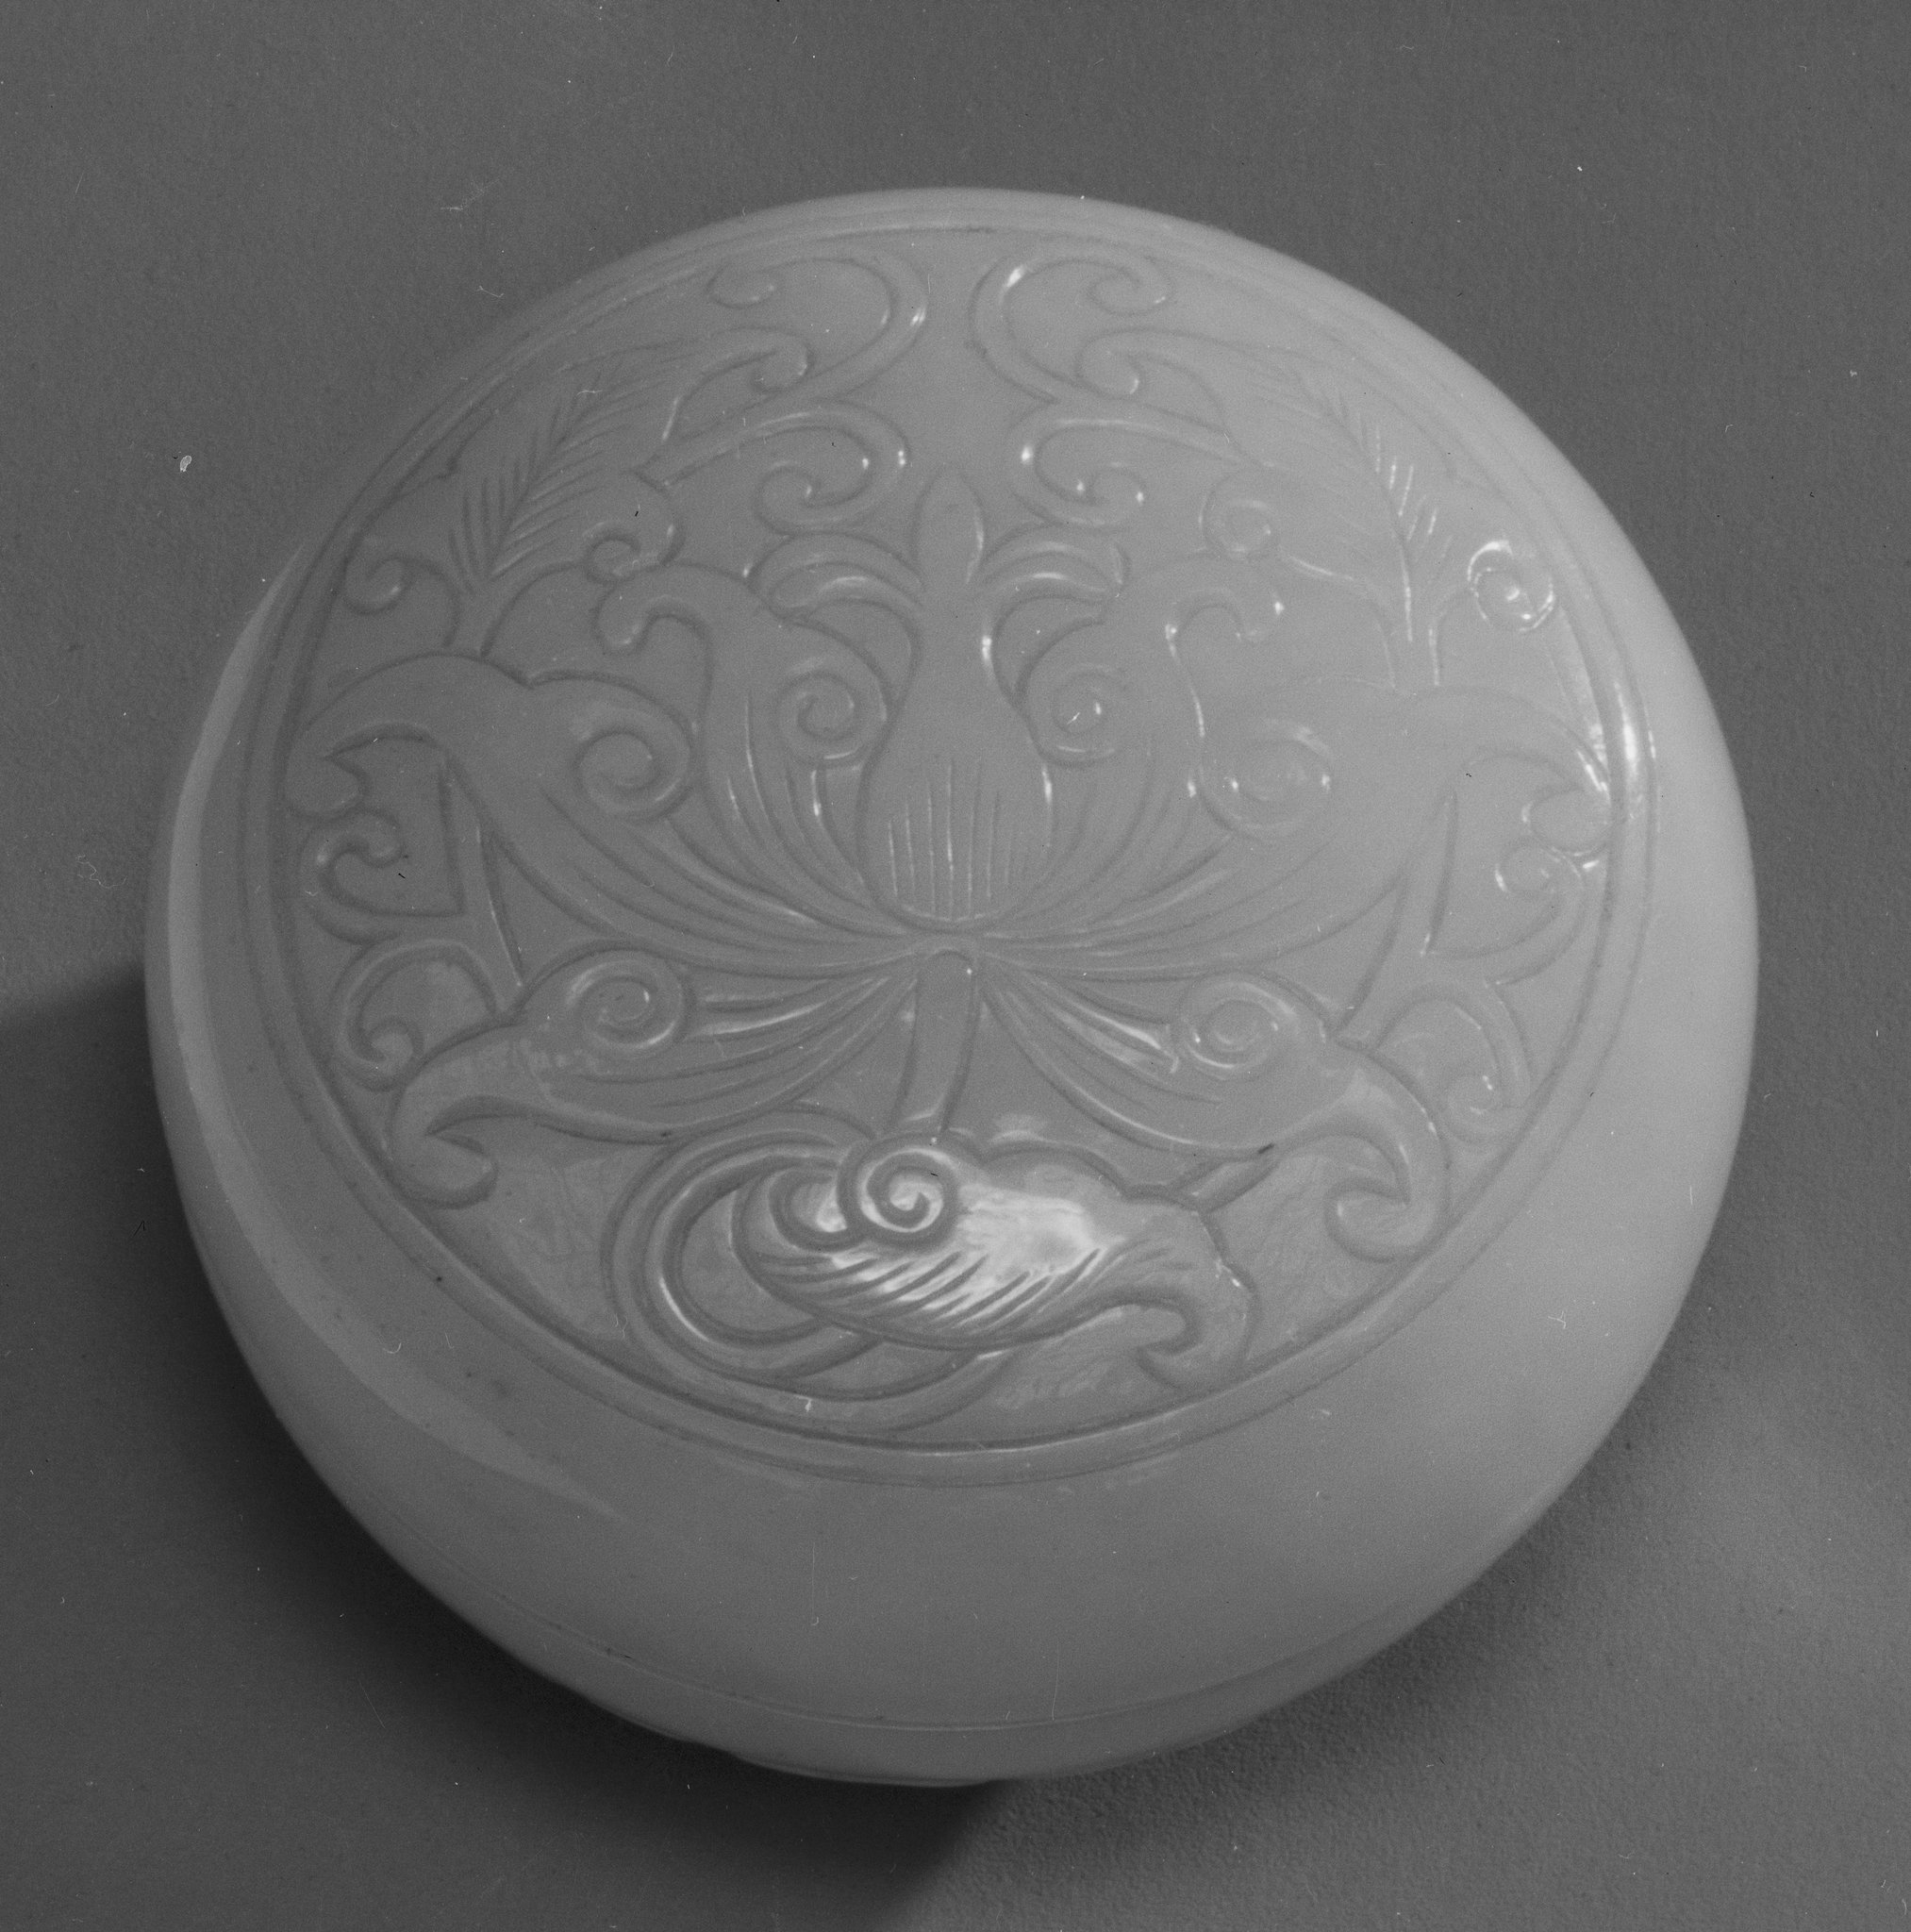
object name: seal box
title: Covered seal box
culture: chinese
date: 1867-1900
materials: jade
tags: leaves